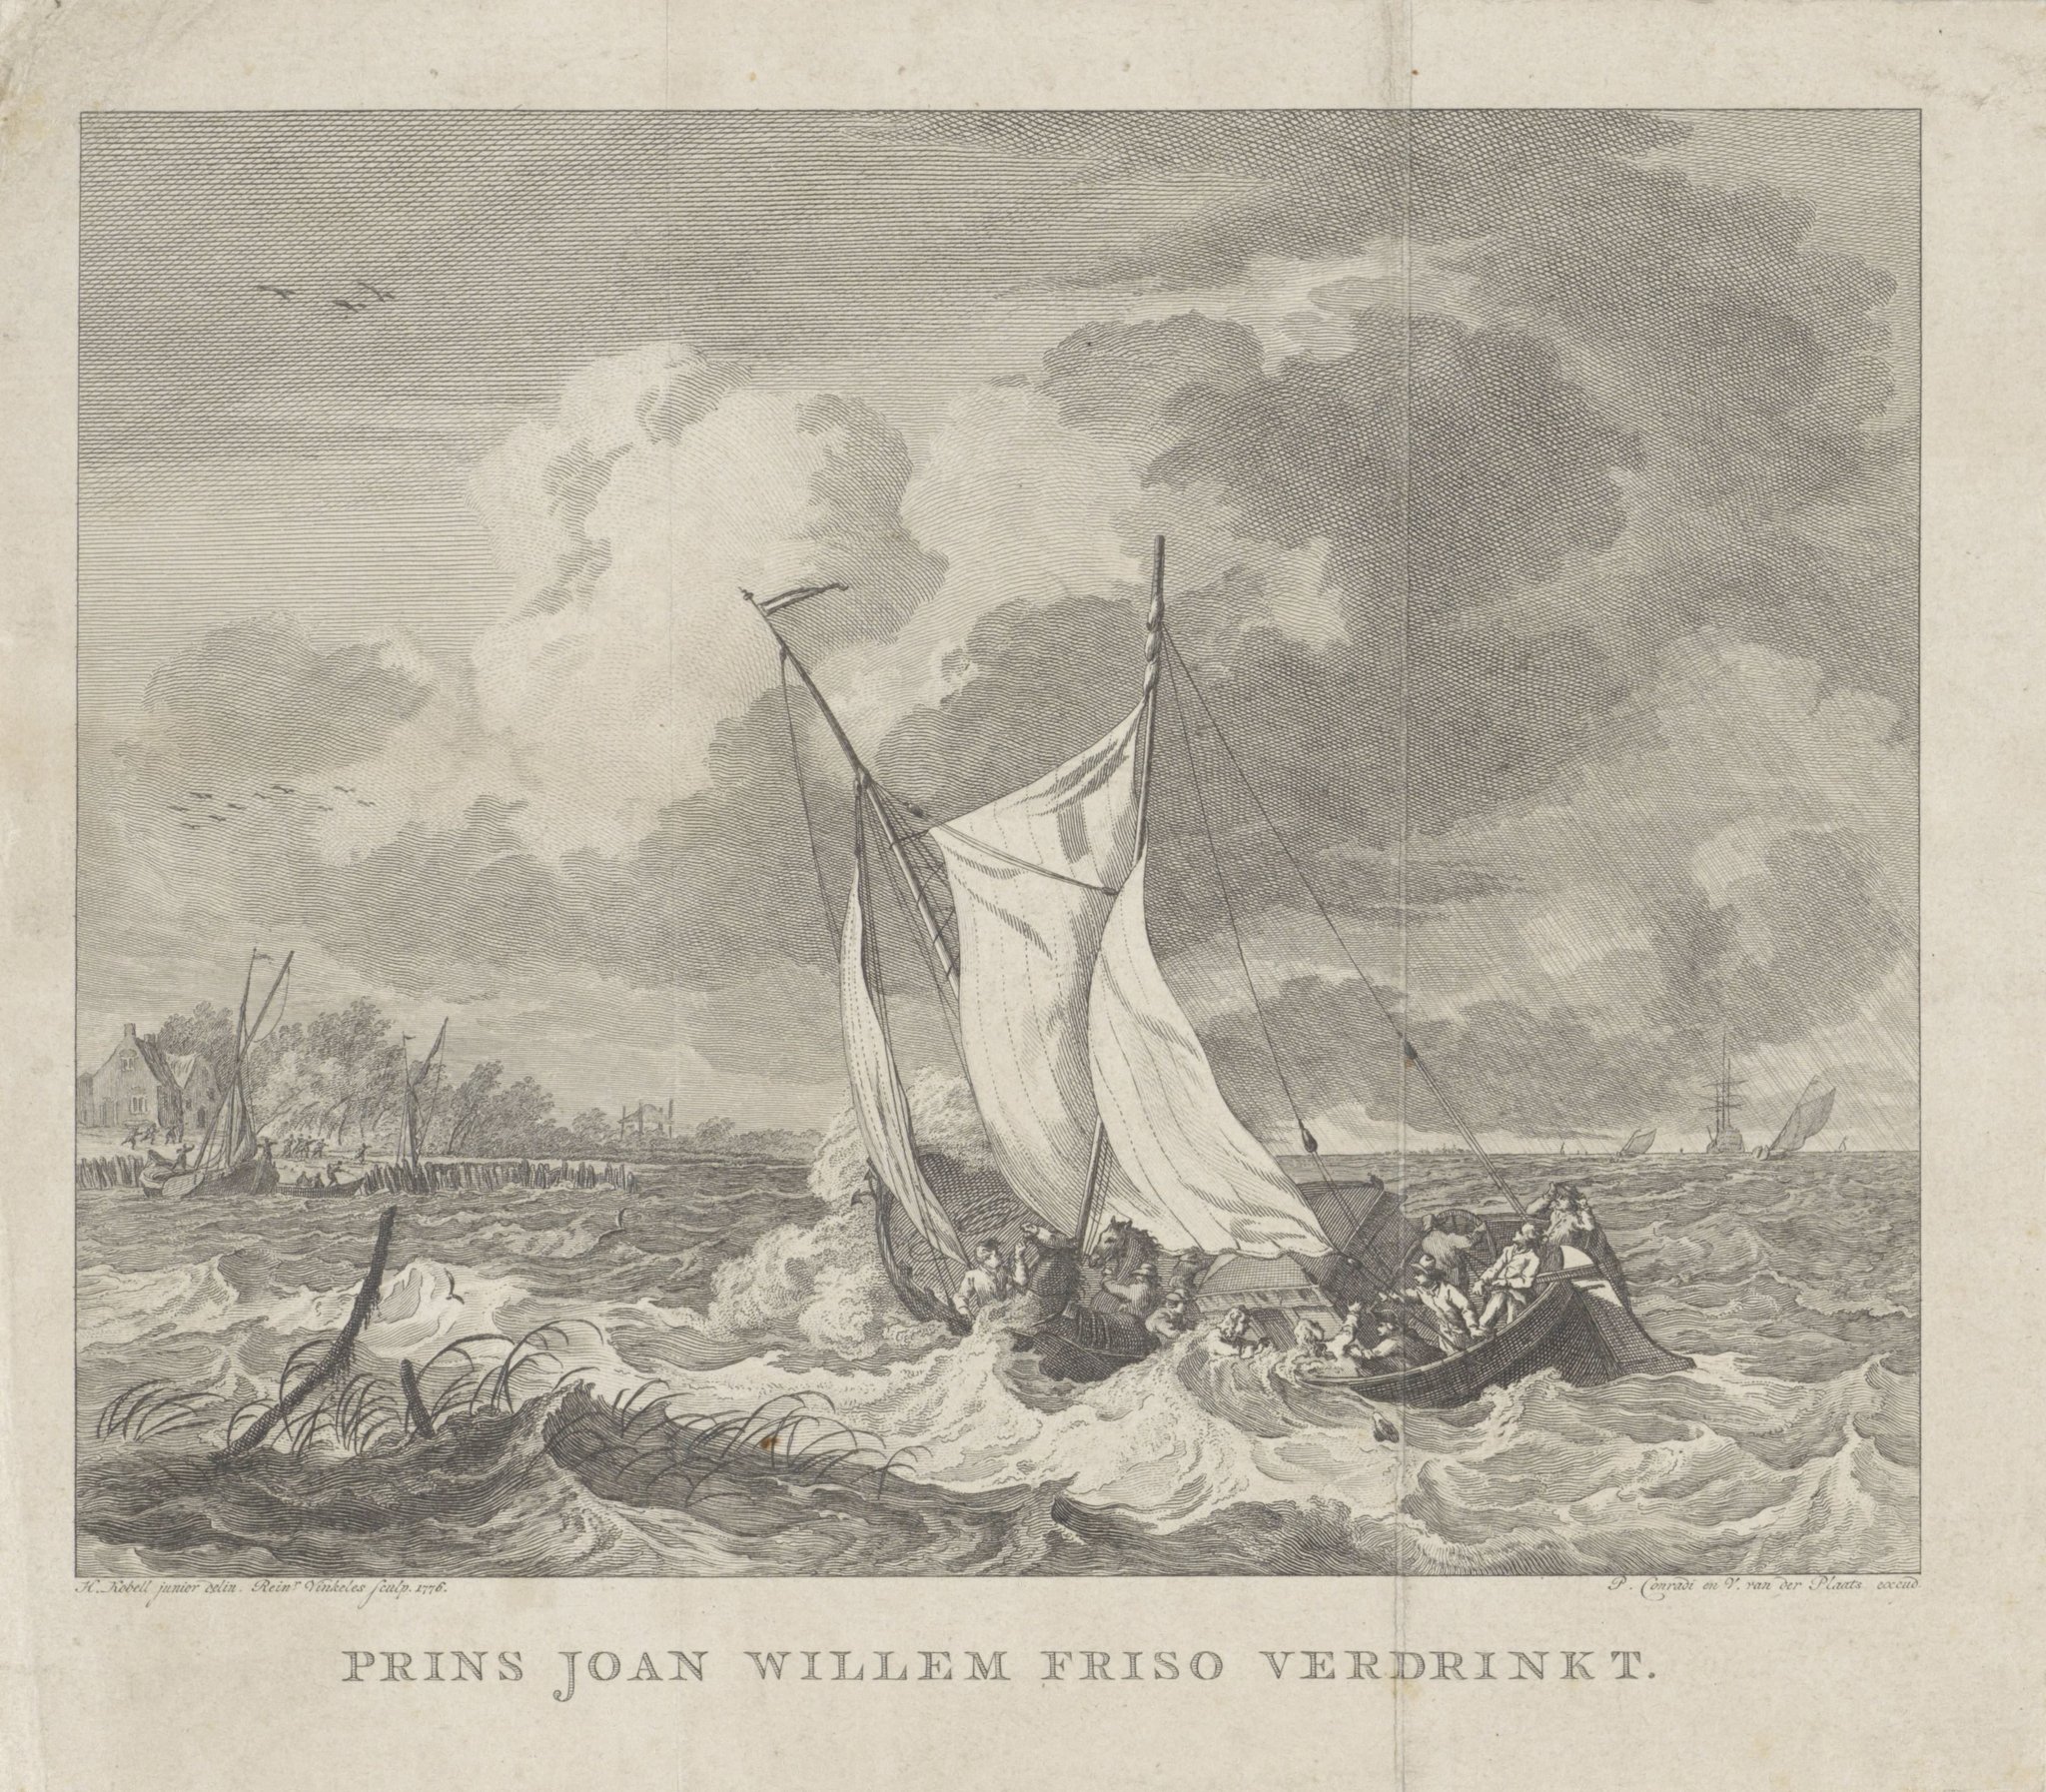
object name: print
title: Prins Joan Willem Friso Verdrinkt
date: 1776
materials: paper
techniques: engraving, etching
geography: amsterdam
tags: johan willem friso (prins van oranje-nassau), death by drowning (non-violent)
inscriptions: collector's mark: Lugt 2228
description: Johan Willem Friso, prins van Oranje-Nassau, verdrinkt tijdens het oversteken van de Moerdijk als de boot tijdens zwaar weer op 14 juli 1711 in problemen raakt.